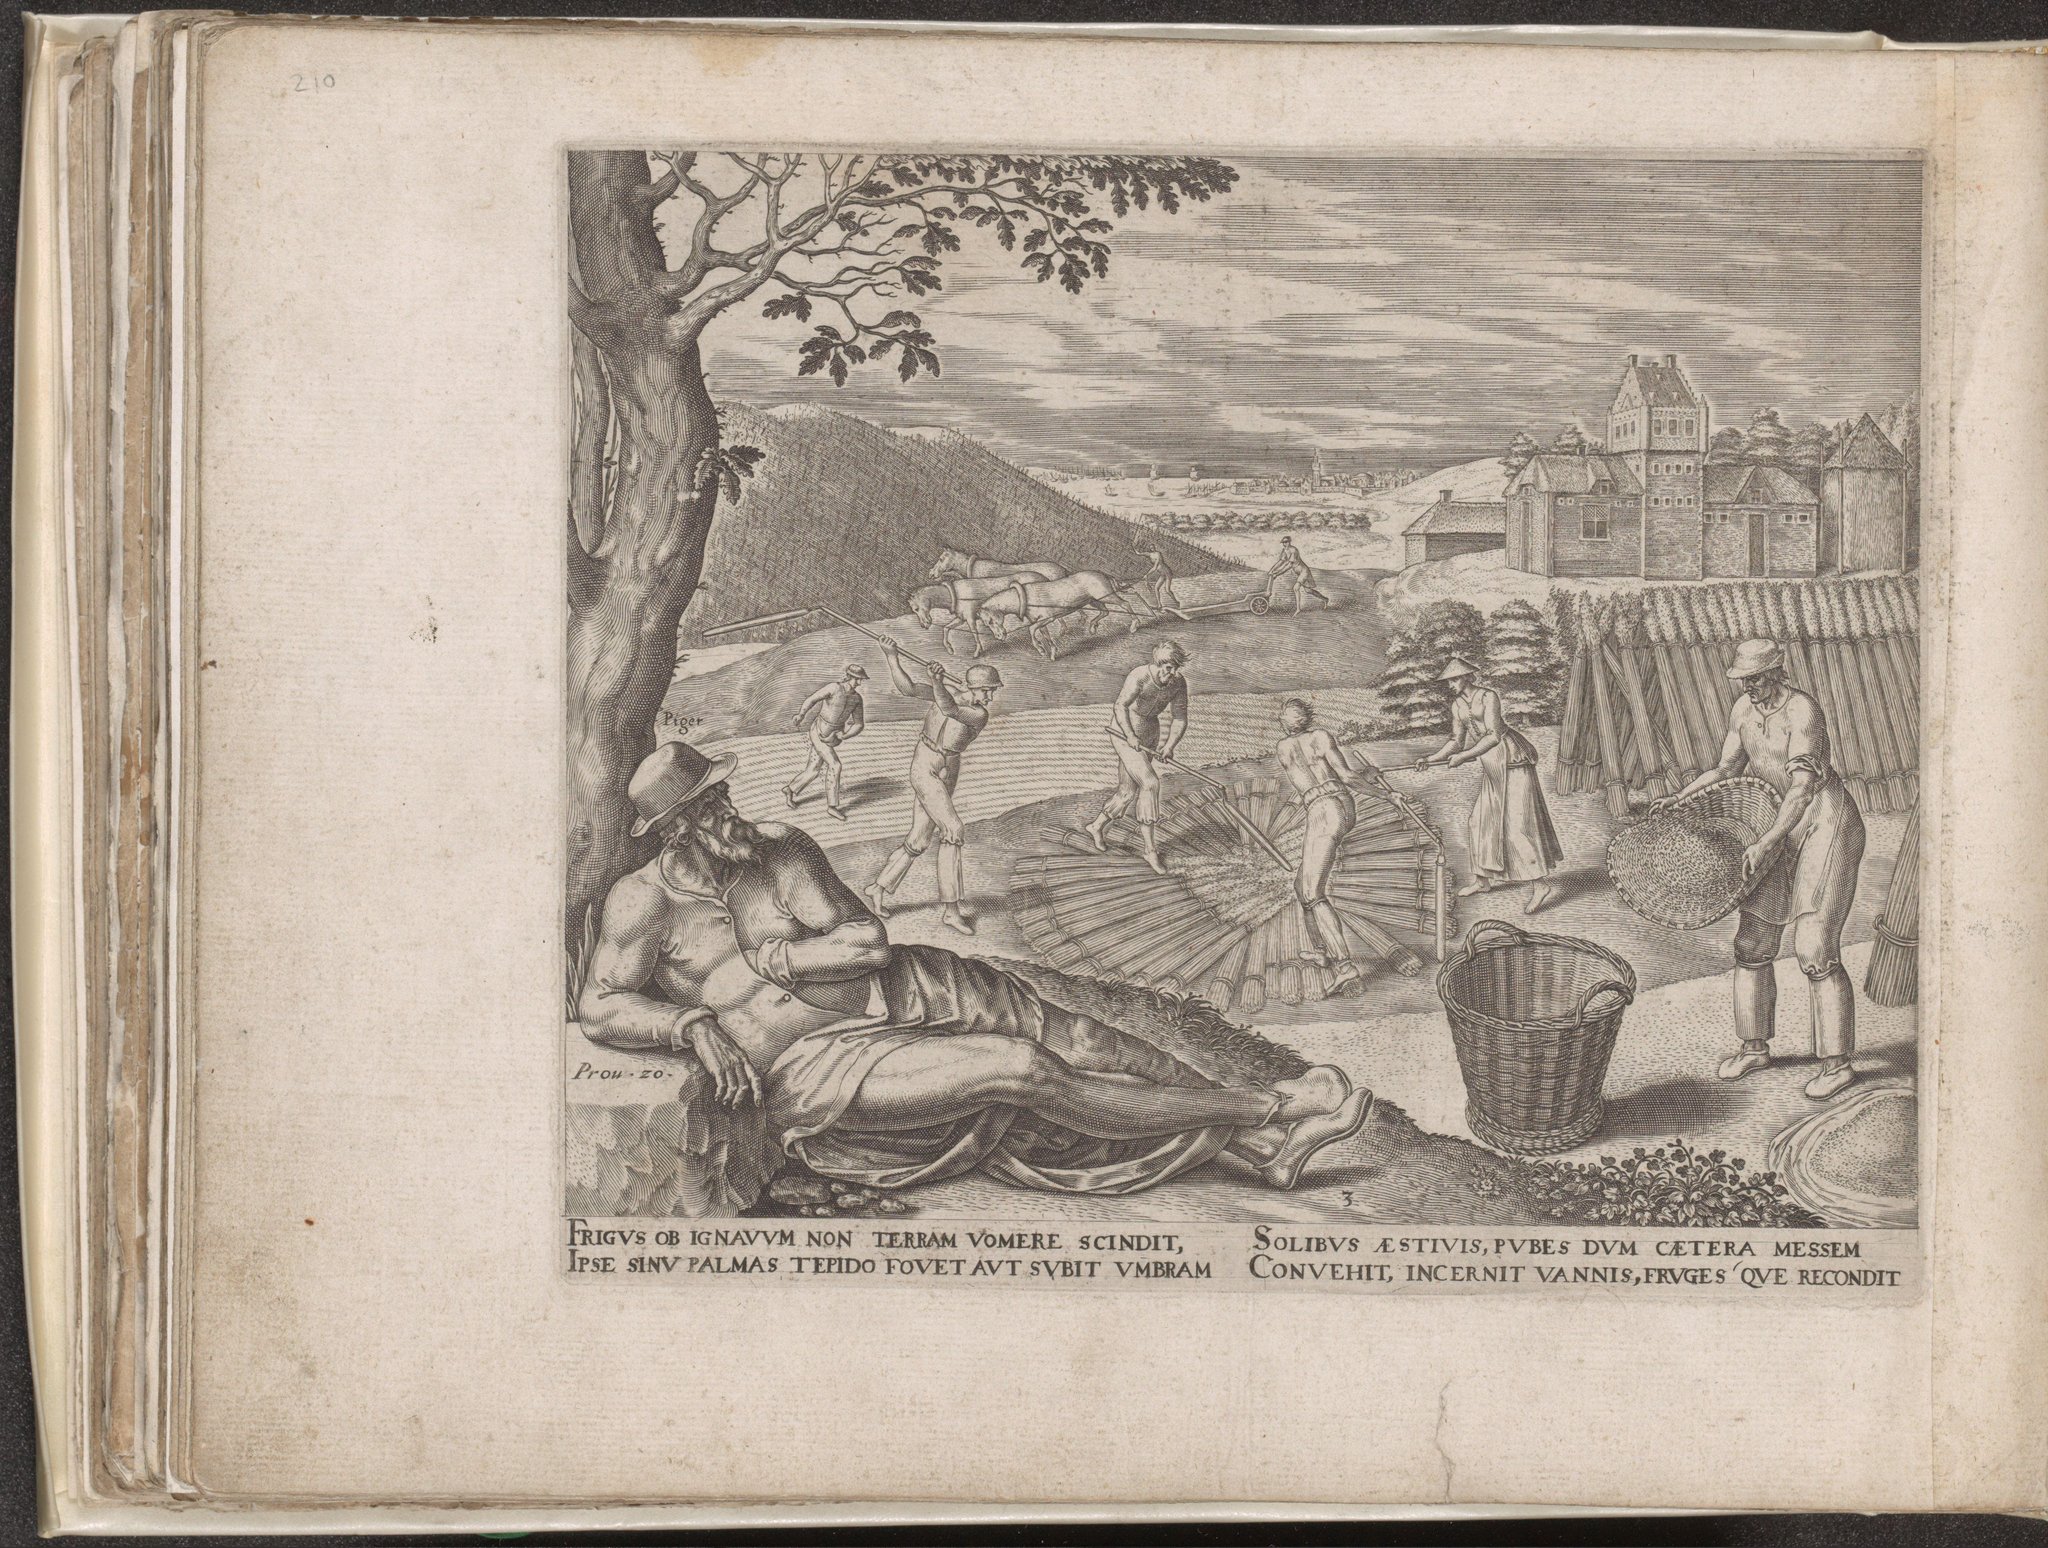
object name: print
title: De luiaard ligt onder een boom tijdens het oogsten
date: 1563-1567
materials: paper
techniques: engraving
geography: haarlem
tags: threshing, rest during harvest (eating, dancing, making love, etc.)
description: In een heuvelachtig landschap zijn boeren met de graanoogst bezig. Enkele mannen dorsen het graan. Op de achtergrond bewerken twee mannen een akker met een ploeg en zaait een man nieuw koren in. De luiaard ligt onder een boom en slaapt. Naar de Bijbeltekst in Spr. 20:4. Onder de voorstelling een verklarende tekst in het Latijn. Deze prent maakt deel uit van een album.